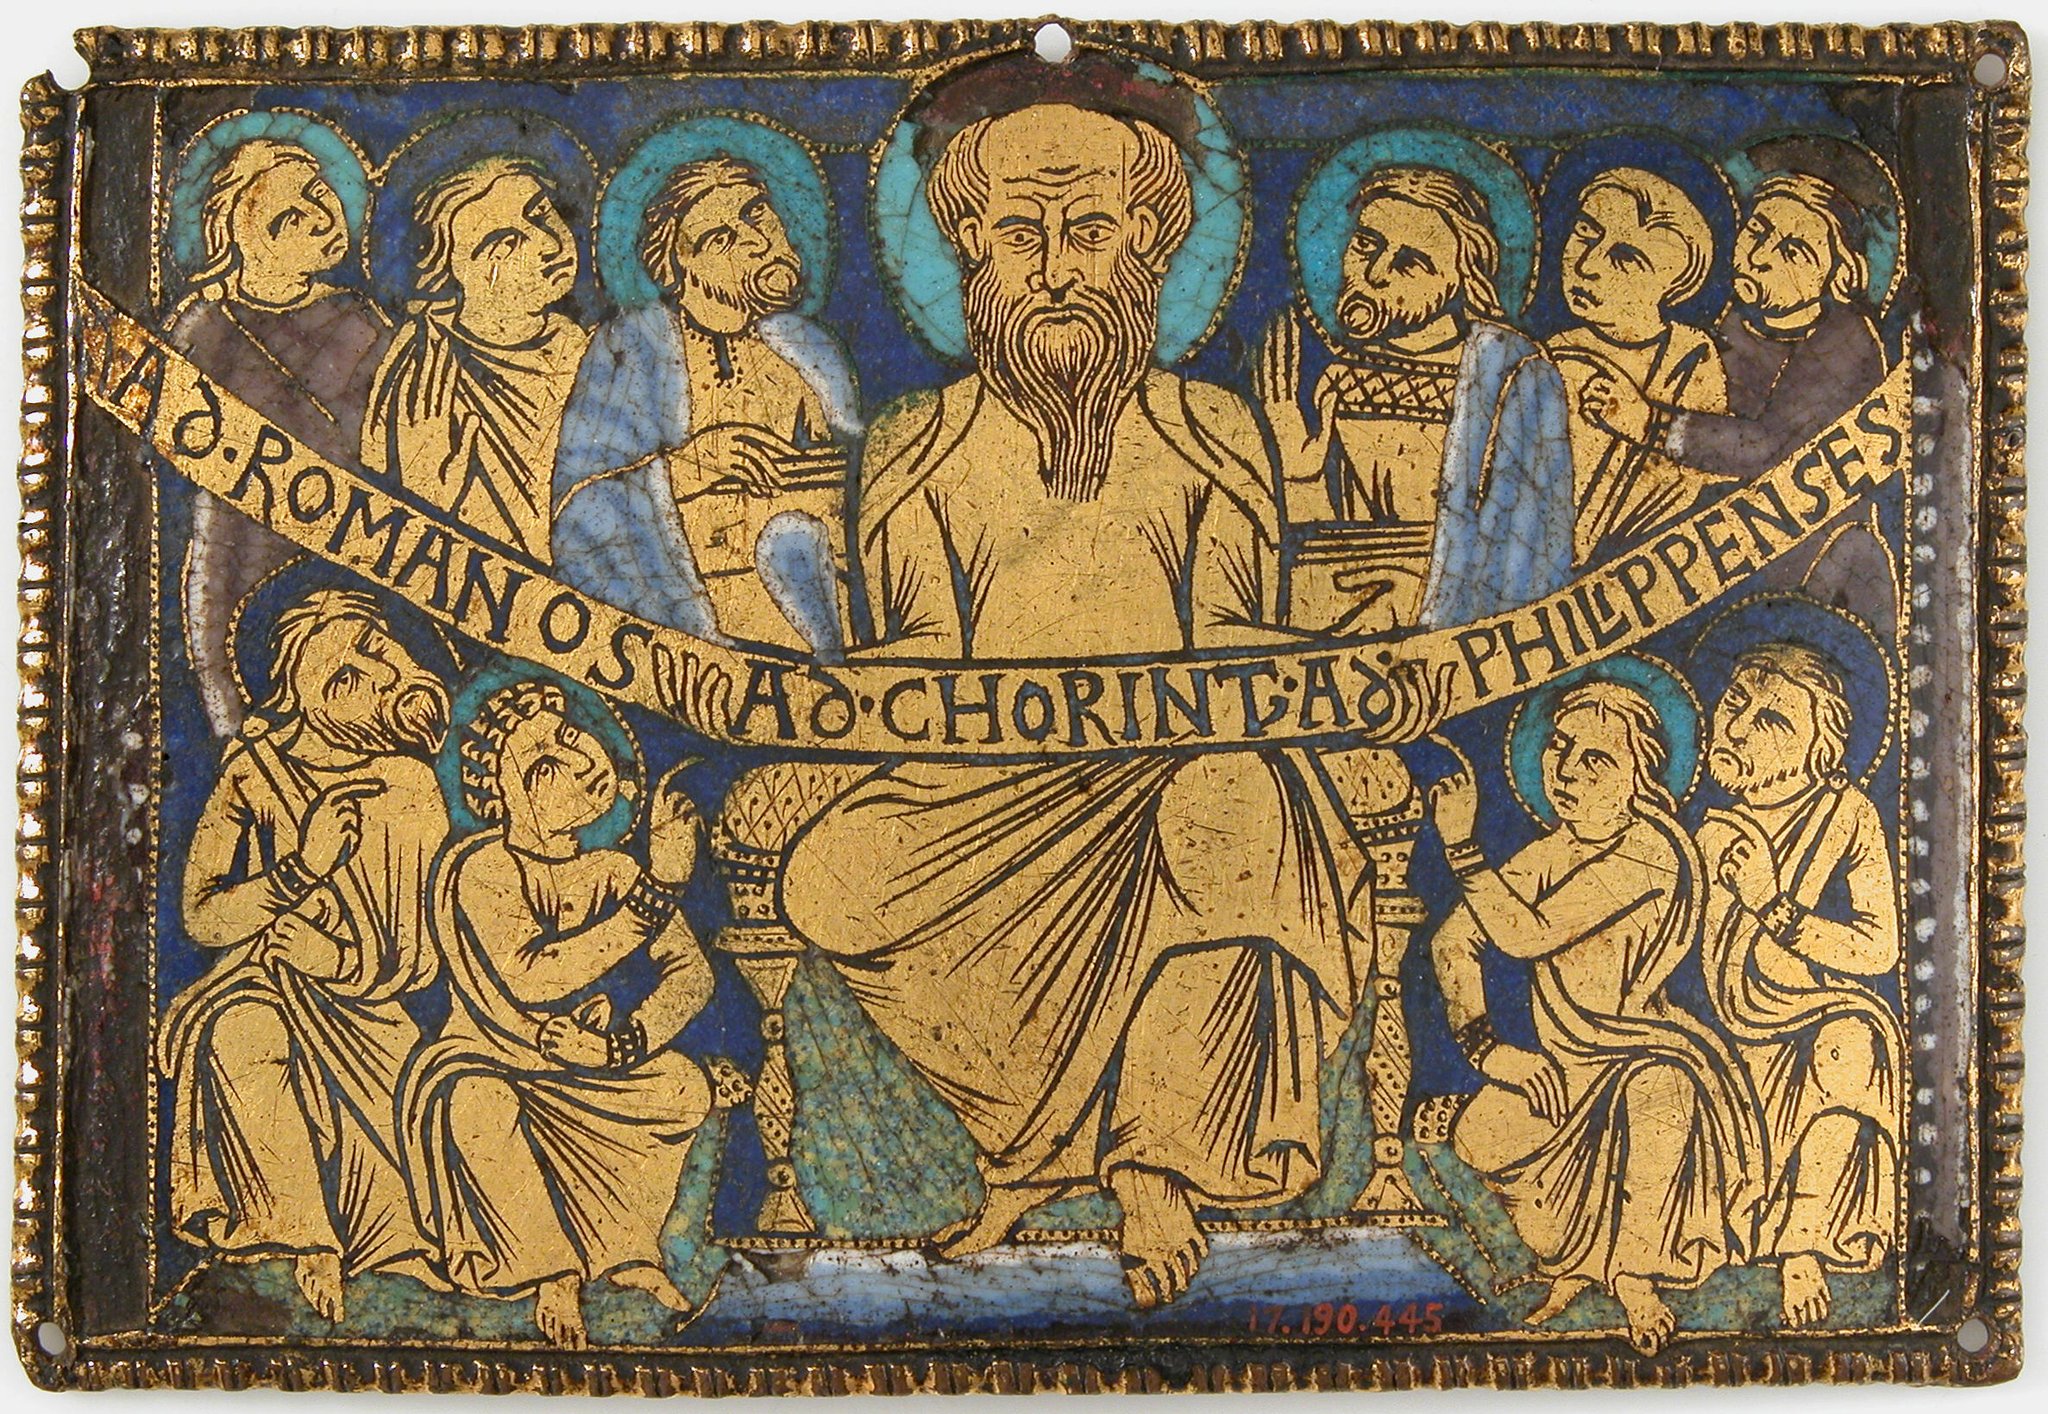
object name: plaque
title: Plaque with Saint Paul and His Disciples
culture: british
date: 1160-1180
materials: copper, enamel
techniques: enamel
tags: saint paul